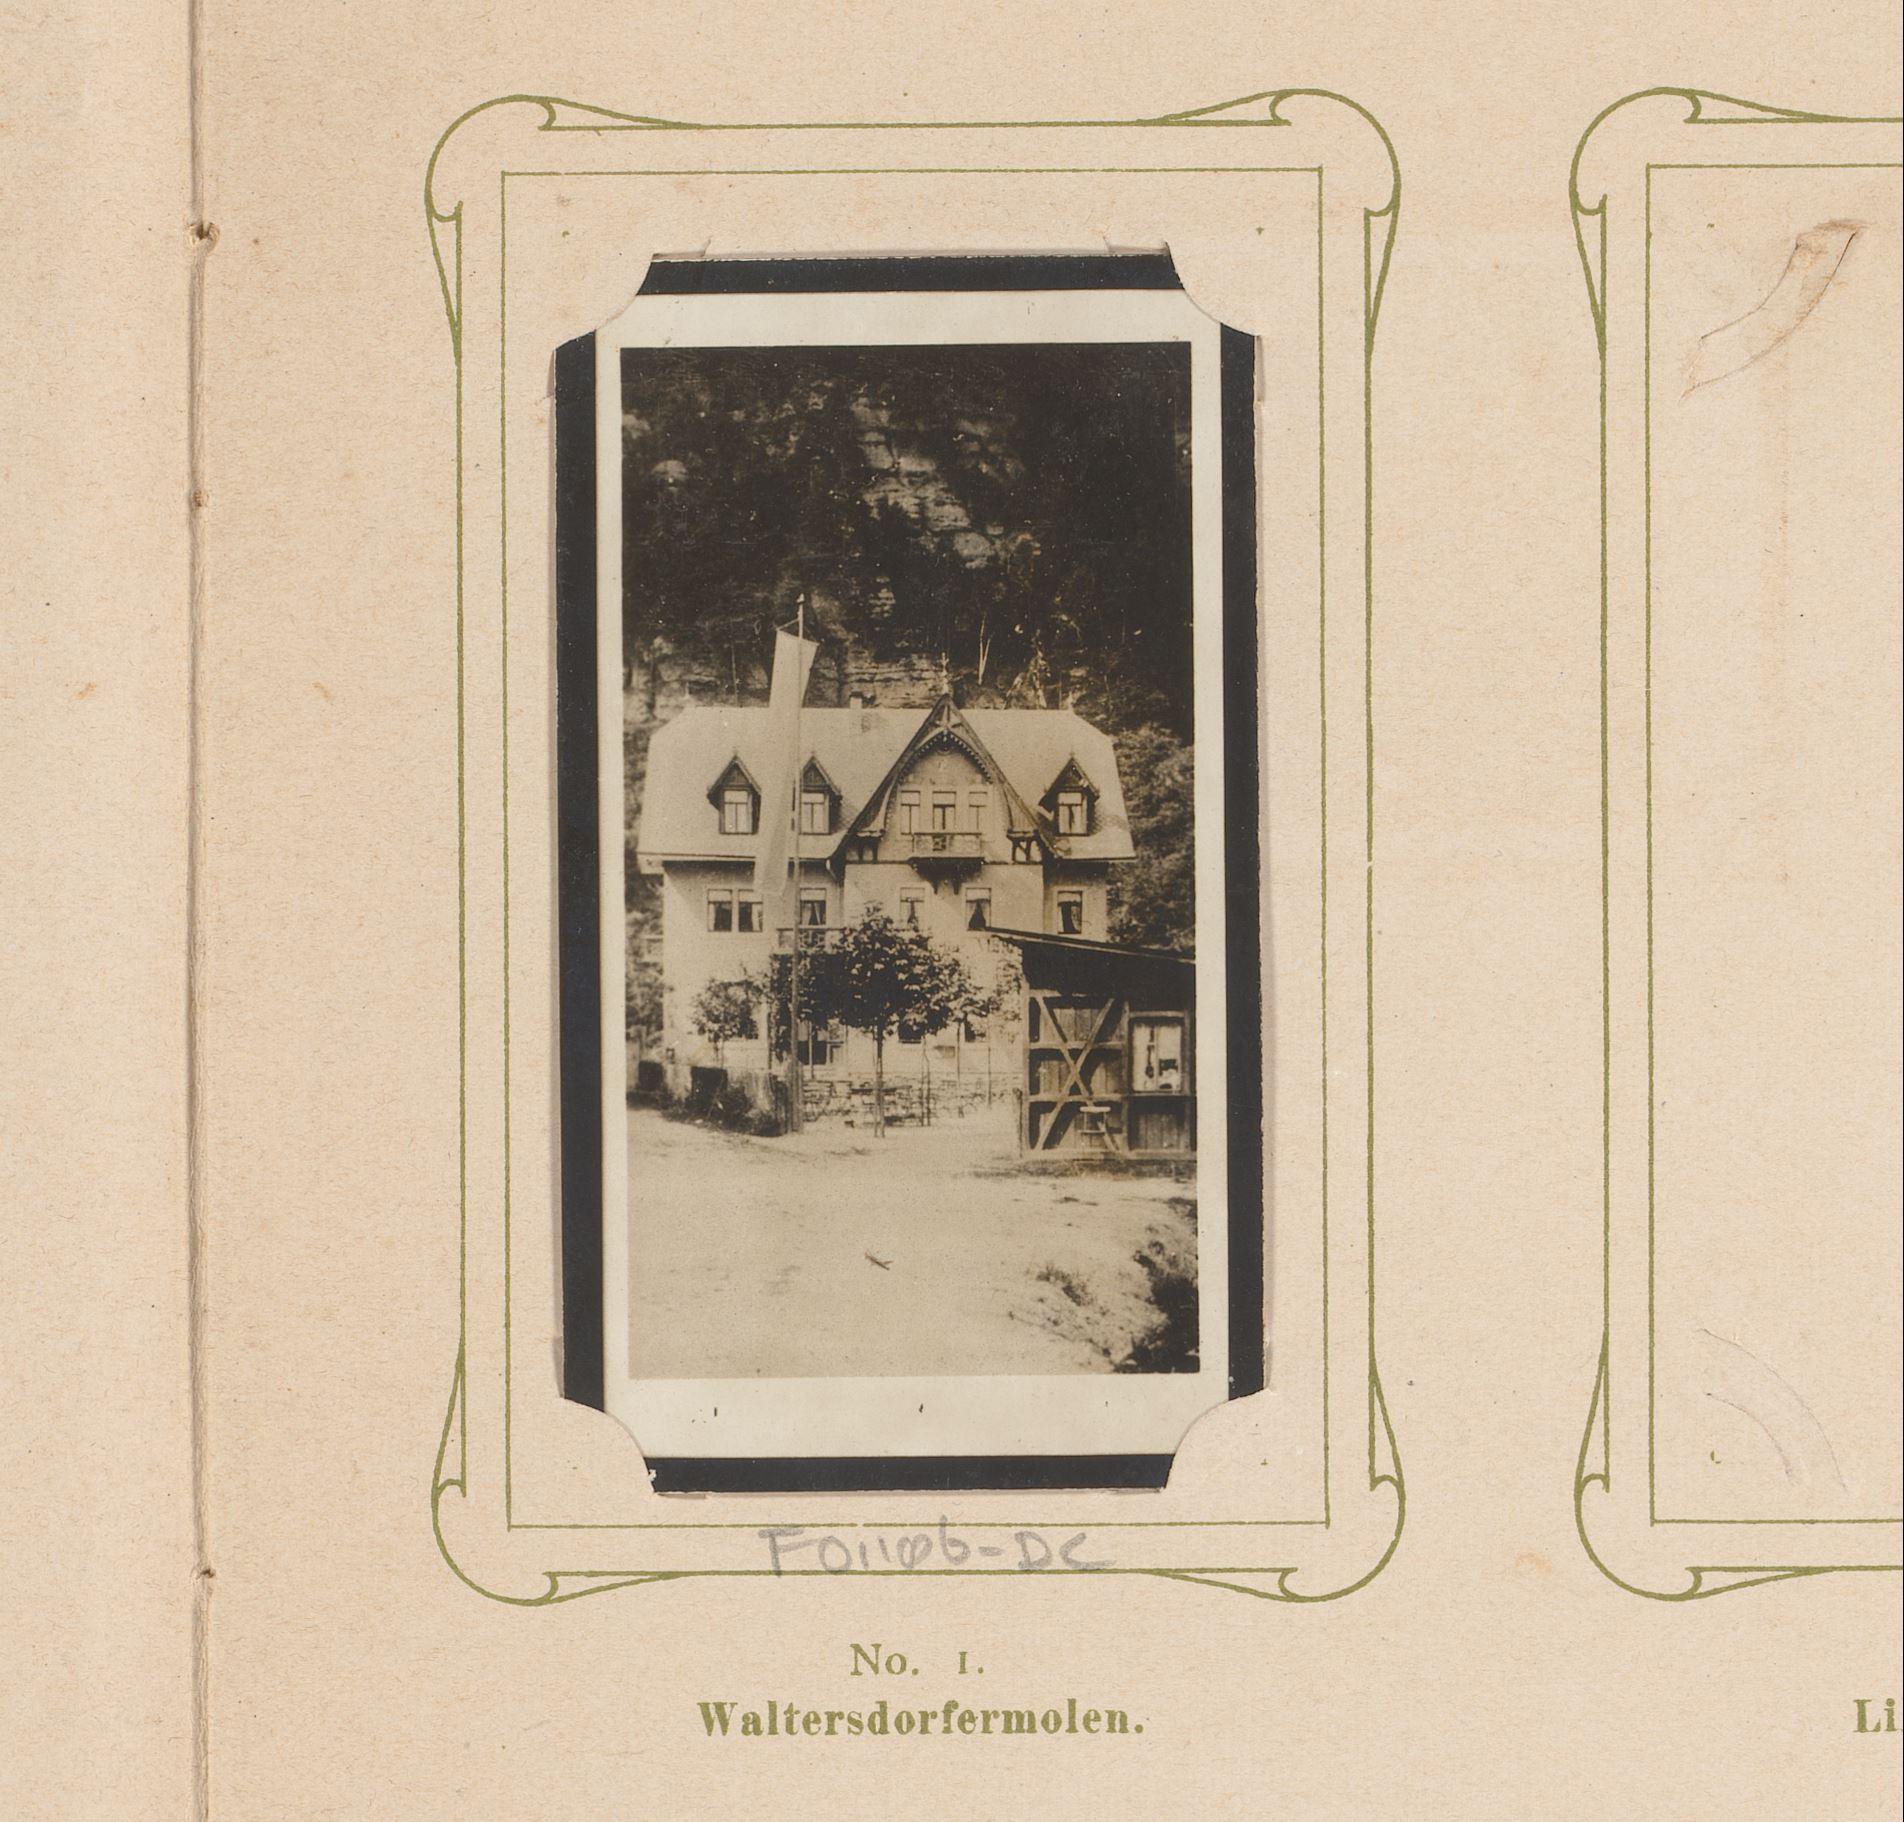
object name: photograph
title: Gezicht op de Waltersdorfer Mülhe te Saksen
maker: Anonymous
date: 1904-1905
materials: photographic support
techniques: gelatin silver print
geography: saxony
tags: façade (of house or building)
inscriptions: inscription: ‘No. 1./ Waltersdorfermolen.’